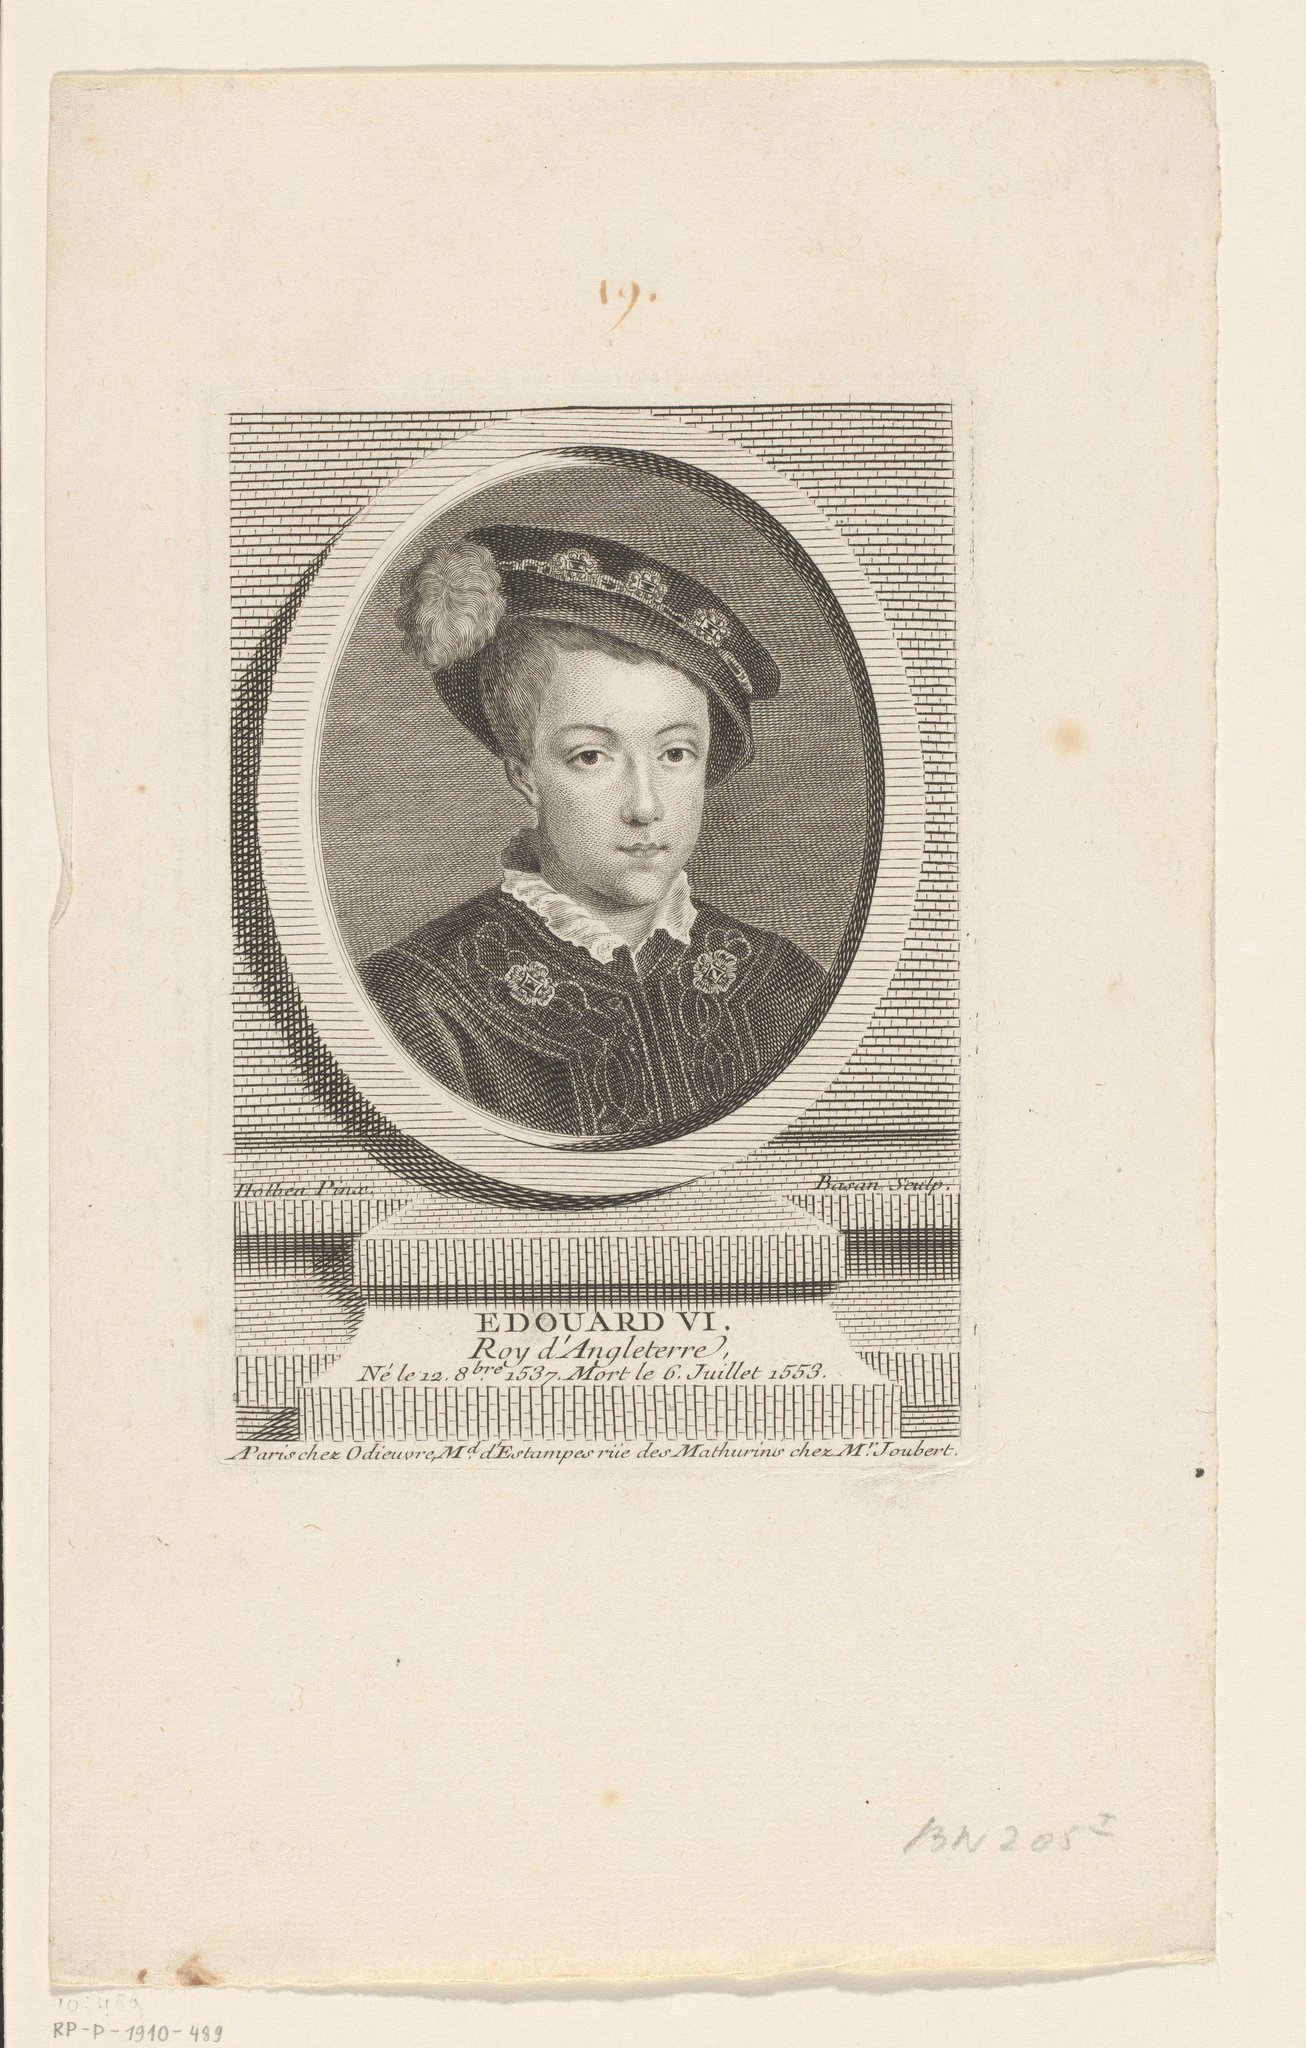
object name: print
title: Edouard VI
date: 1755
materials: paper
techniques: engraving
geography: paris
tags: ornament ~ medallion, historical persons, ruler, sovereign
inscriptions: collector's mark: Lugt 2228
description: Prent uit: Dreux du Radier, Jean-François. L'Europe illustré, contenant l'histoire abregée des souverains, des princes, des prélats, des ministres, (...) en Europe: dans le XVe. siècle compris, jusqu'à présent. Parijs: Michel Odieuvre en André-François Le Breton, 1755, dl. 2.